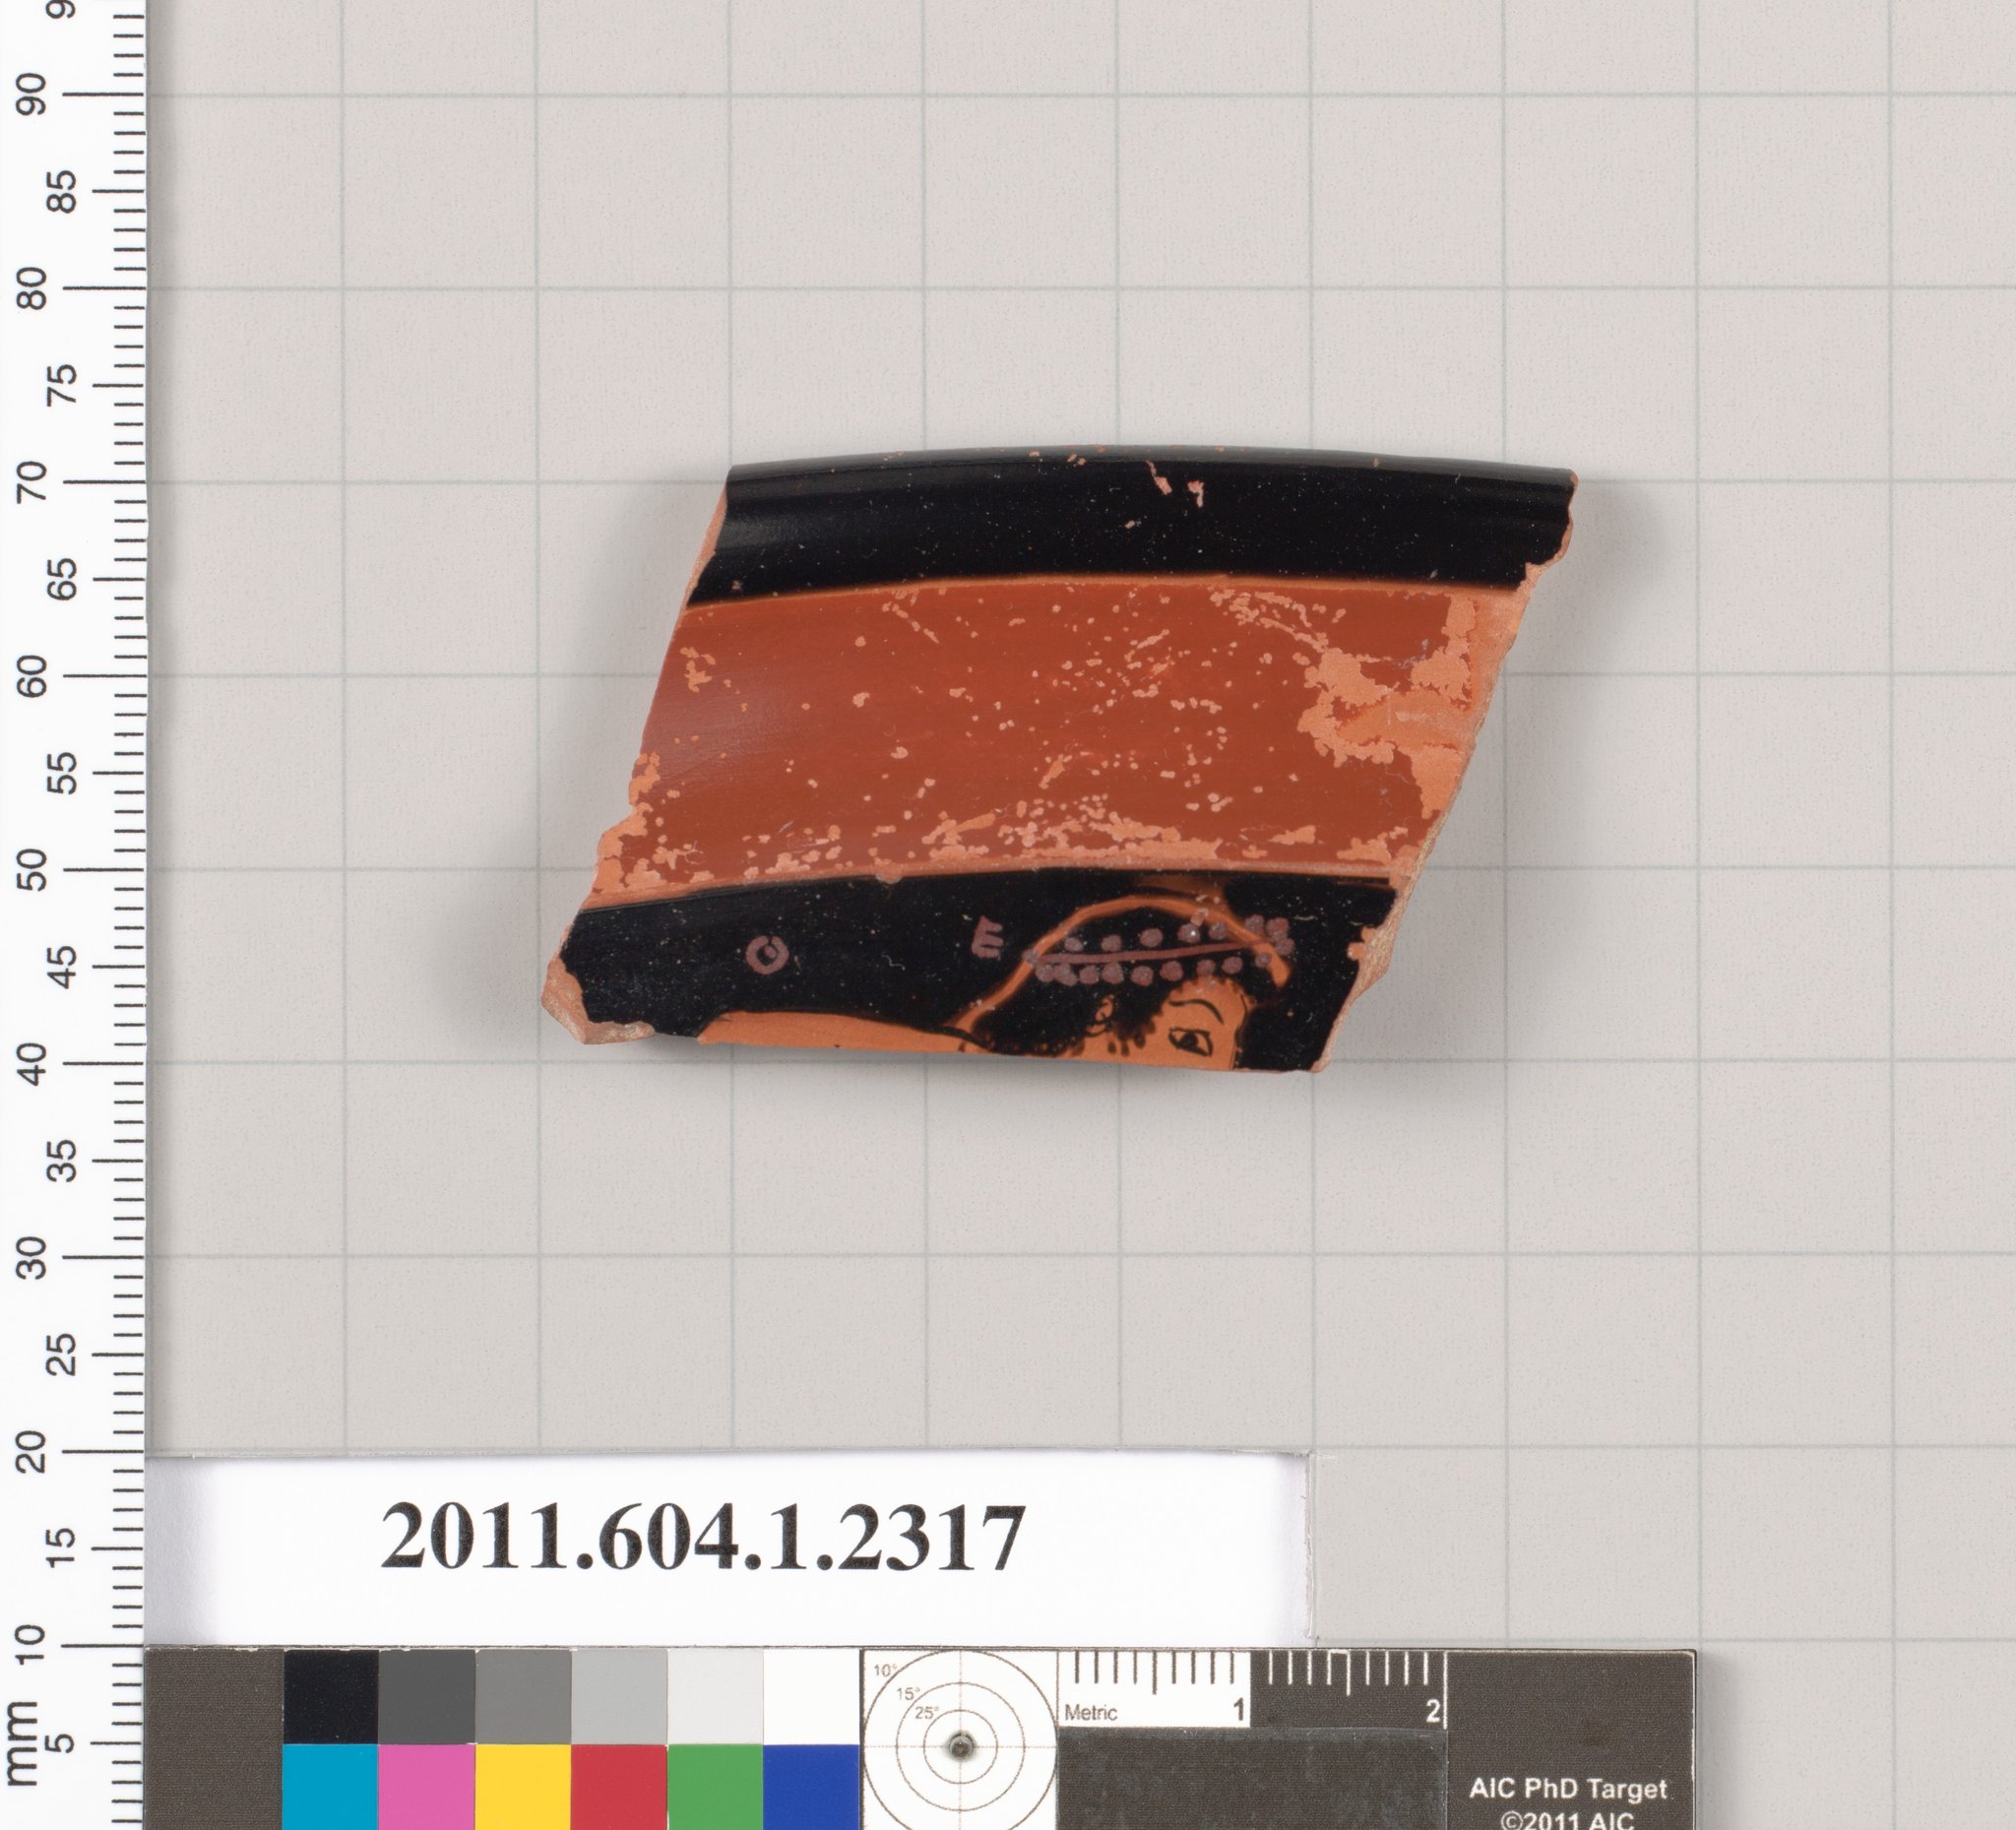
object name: kylix fragment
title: Terracotta rim fragment of a kylix (drinking cup)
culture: greek, attic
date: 534-501 BCE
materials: terracotta